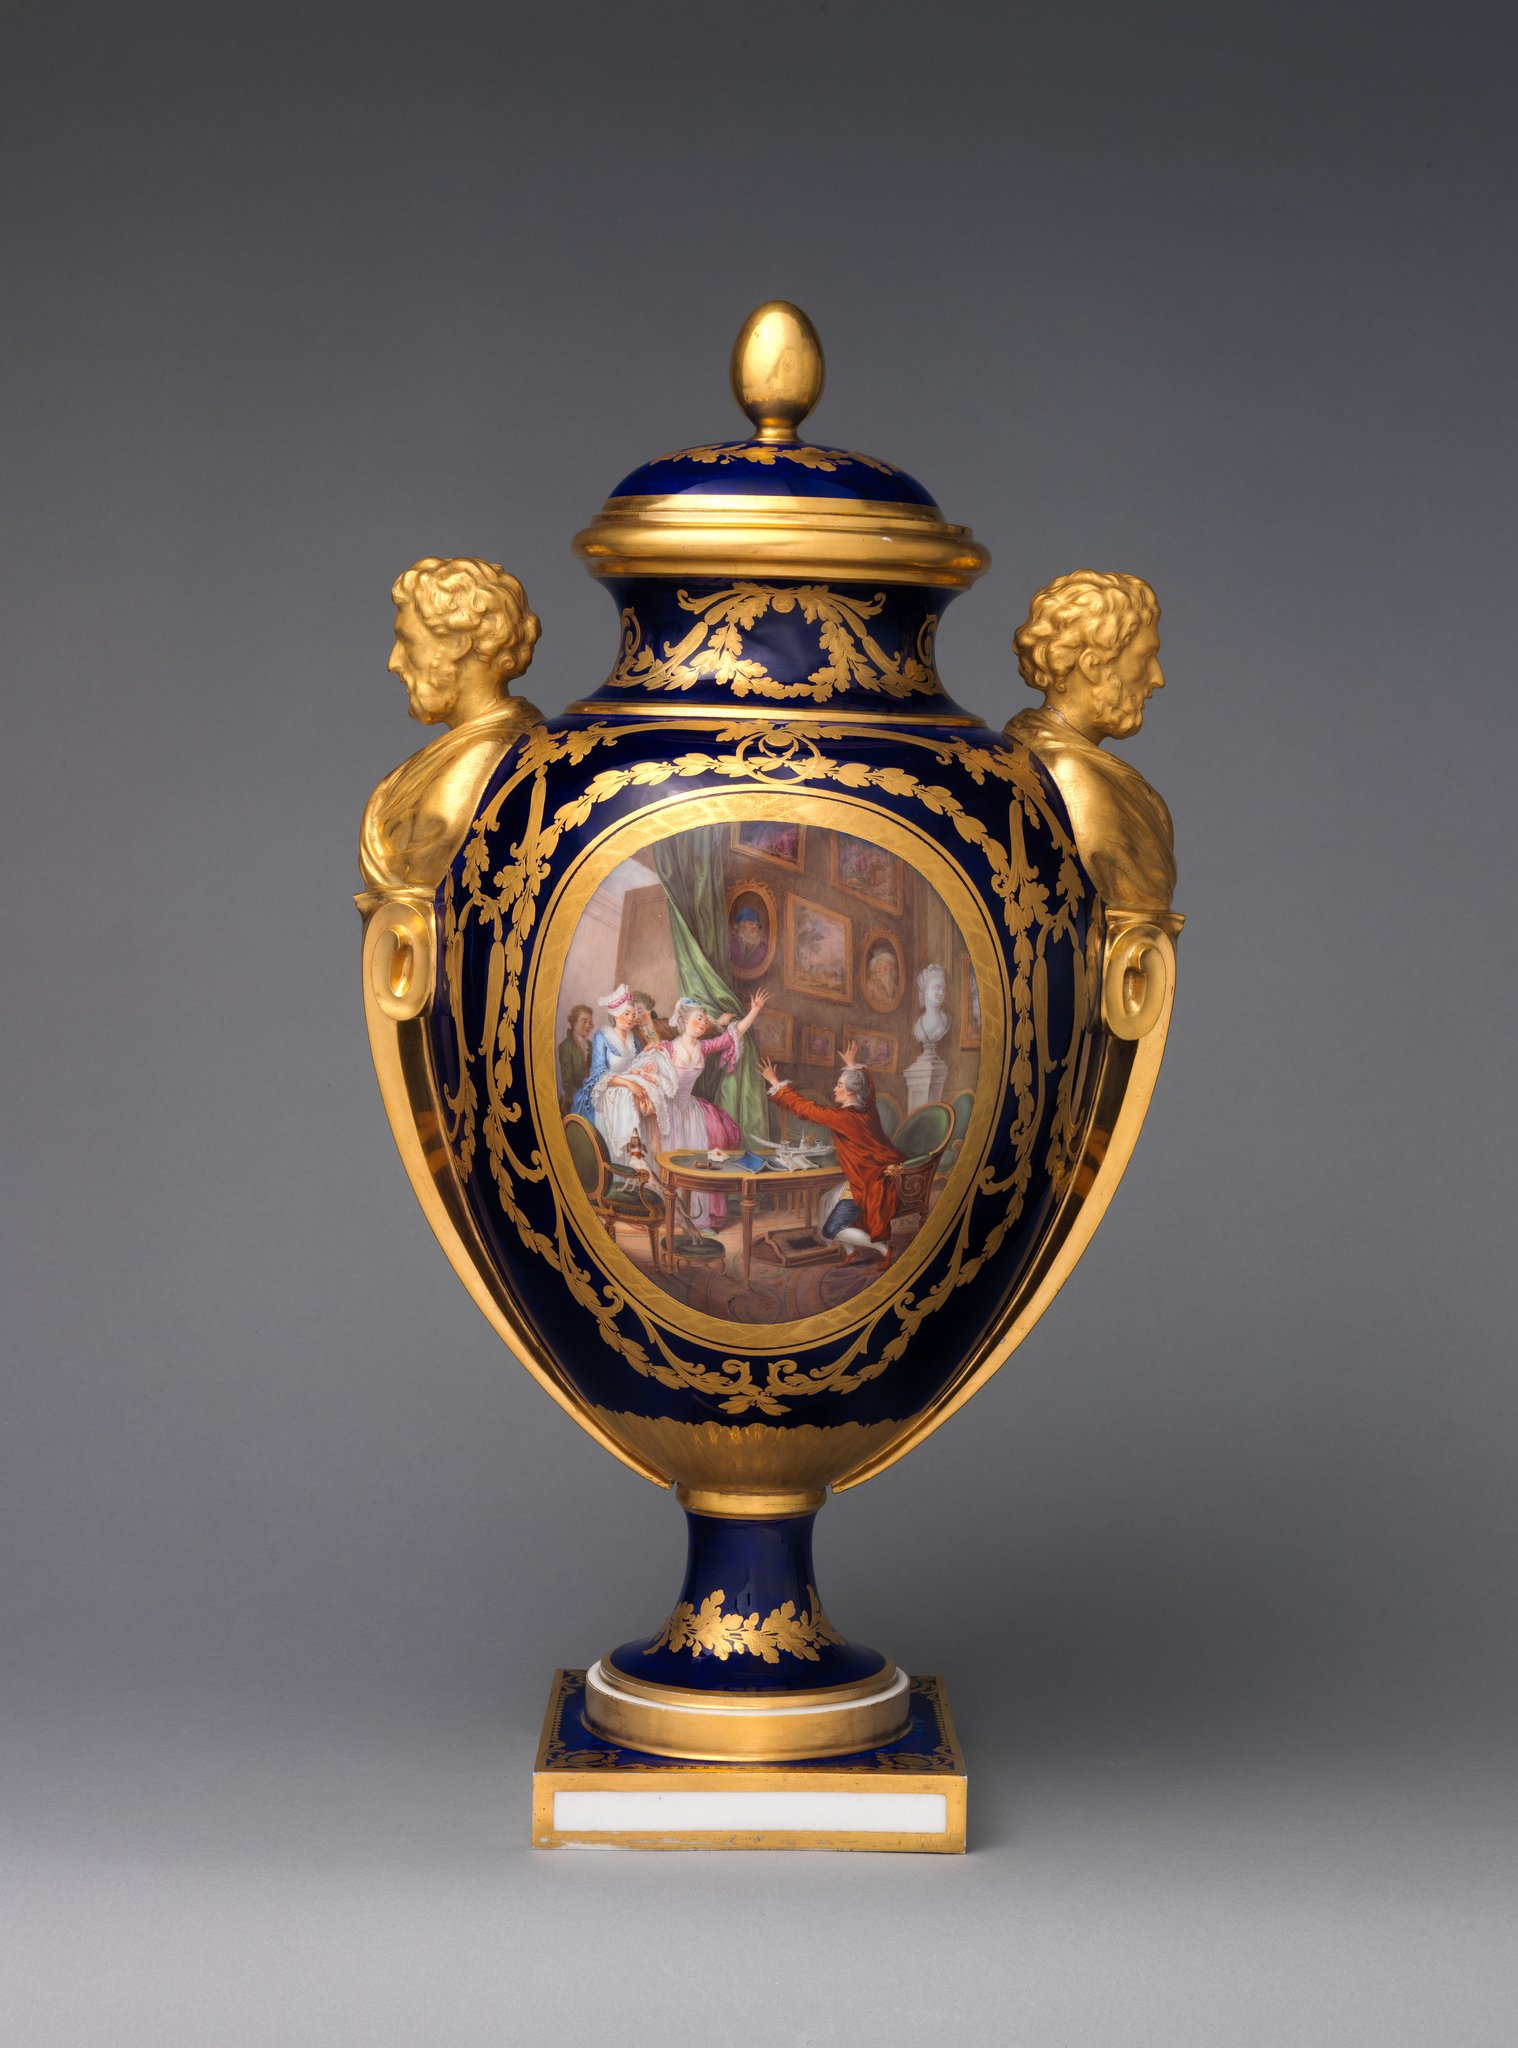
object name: vase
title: Vase with cover (vase des âges) (one of a pair)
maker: sèvres manufactory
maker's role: manufactory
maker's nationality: french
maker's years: 1740-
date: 1788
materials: soft paste porcelain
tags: interiors,men,women,dogs